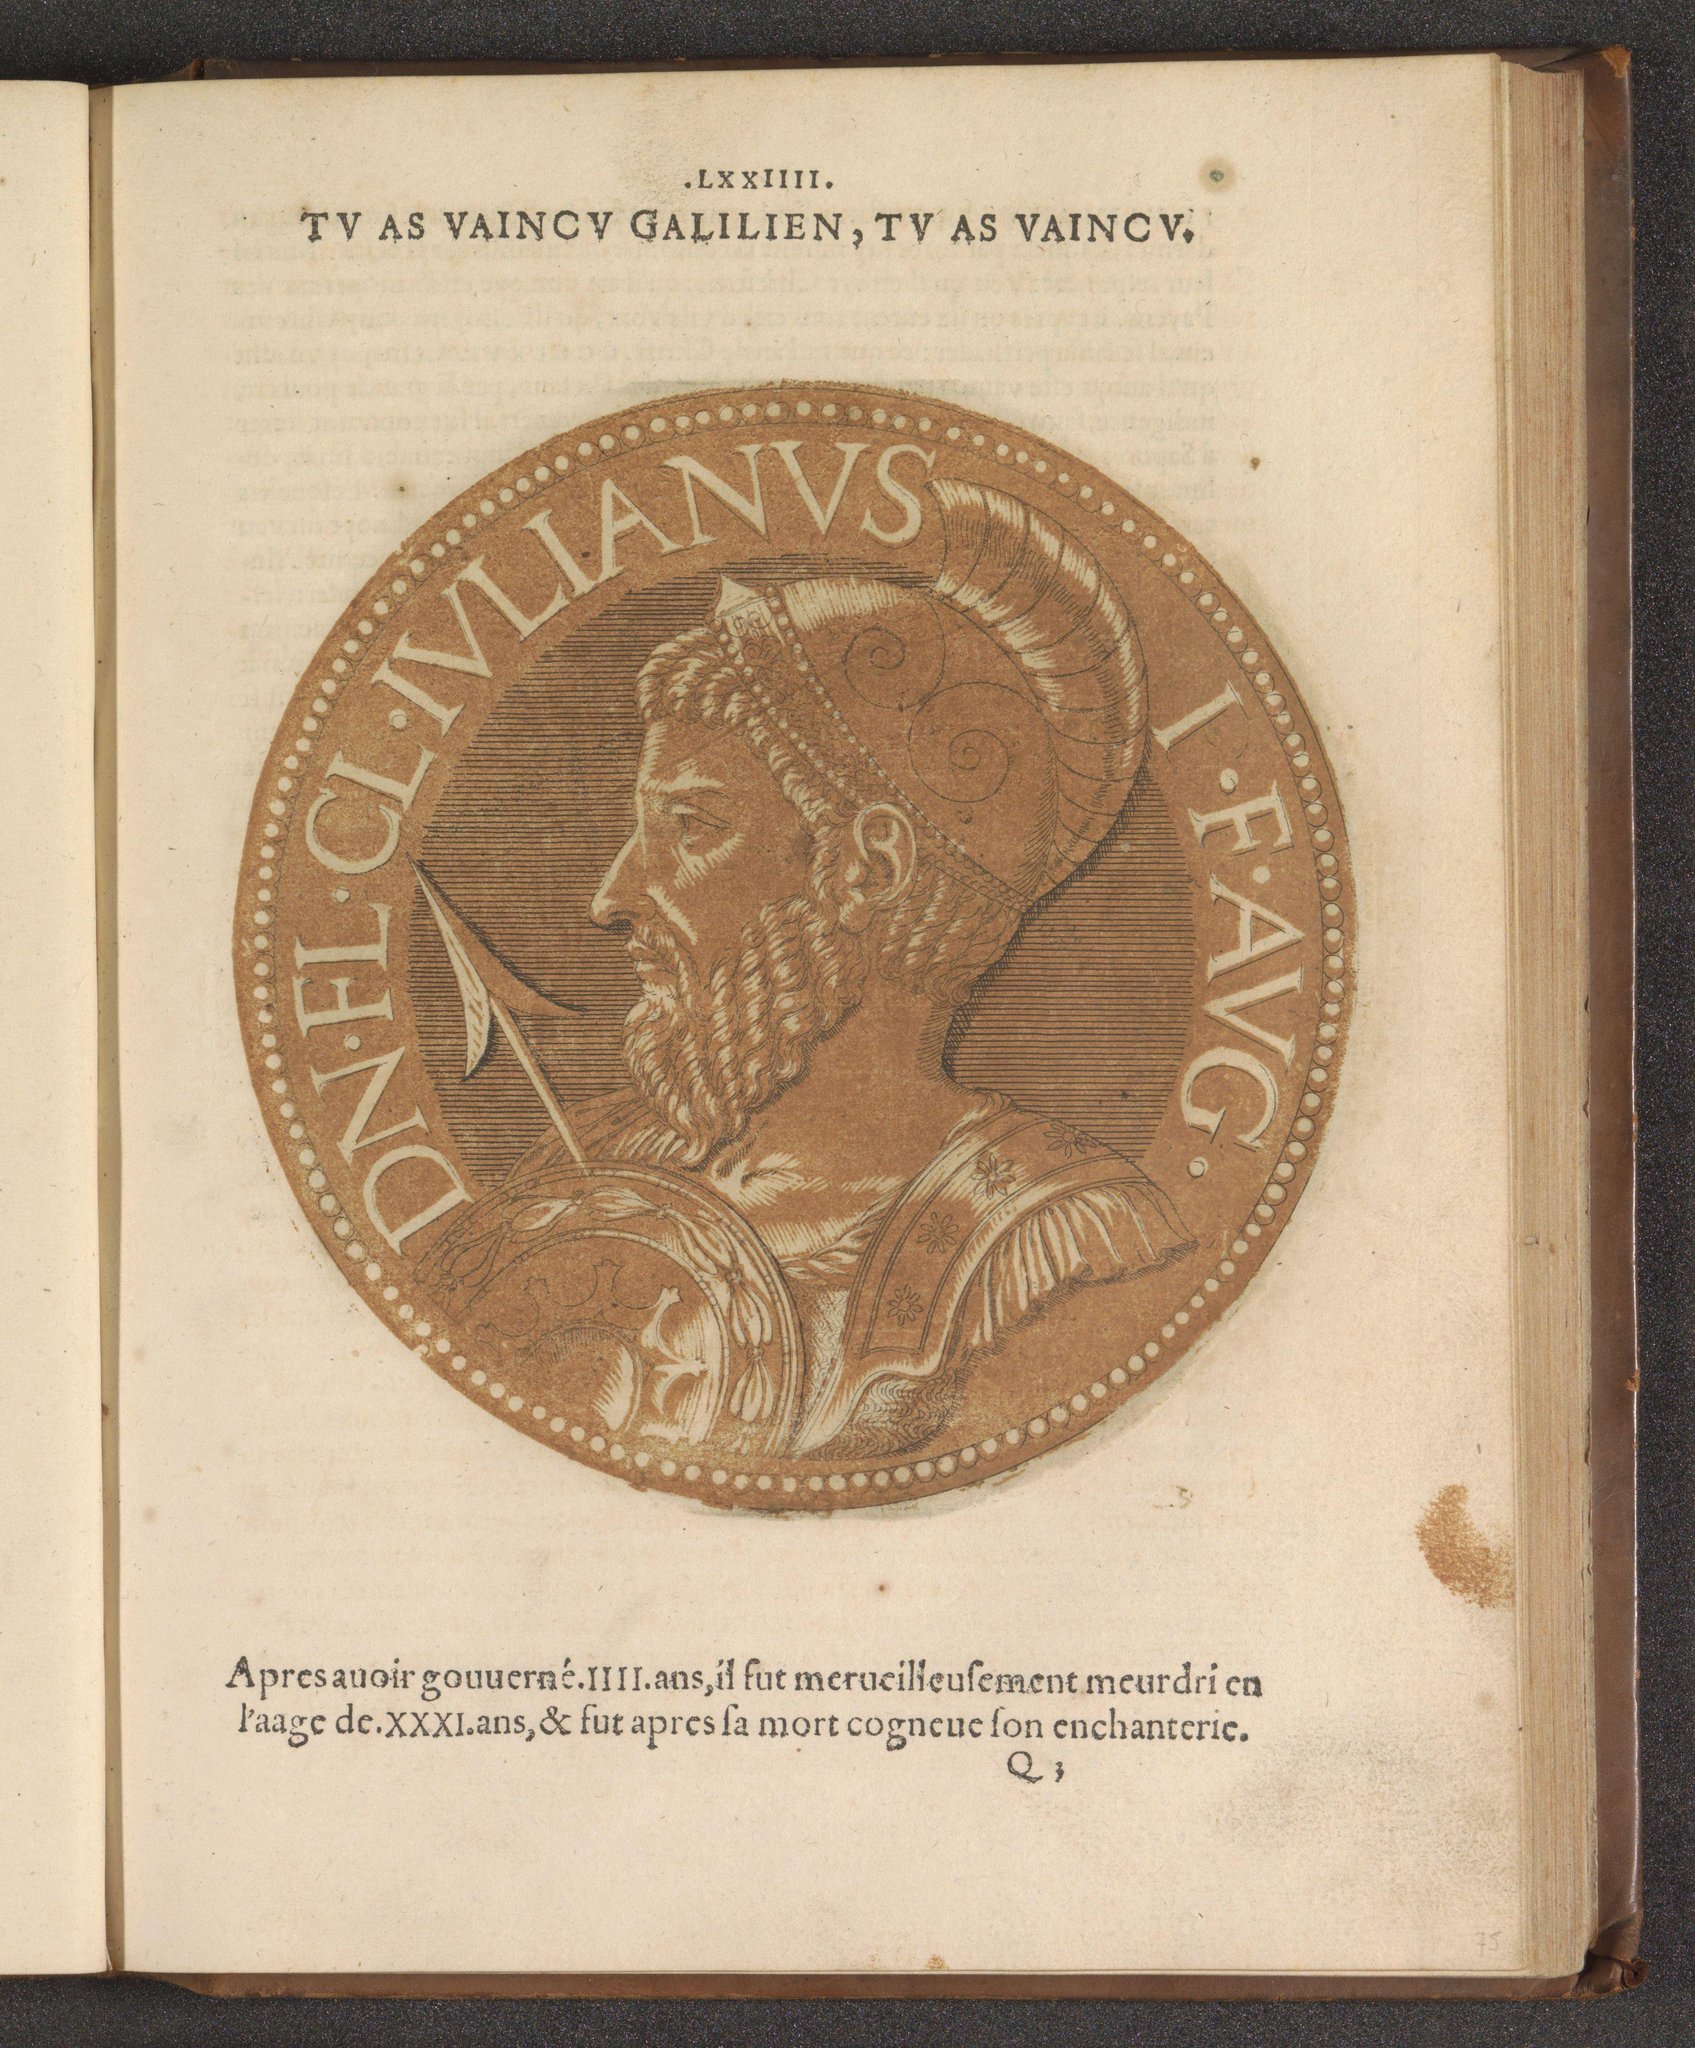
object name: print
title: Les images presque de tous les empereurs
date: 1557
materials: paper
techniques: woodcut, etching, letterpress printing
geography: antwerp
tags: emperor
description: Portret van keizer Julianus Apostata, op een munt met randschrift. De prent maakt deel uit van een boek over de keizers vanaf Julius Caesar tot en met Karel V en zijn broer Ferdinand.